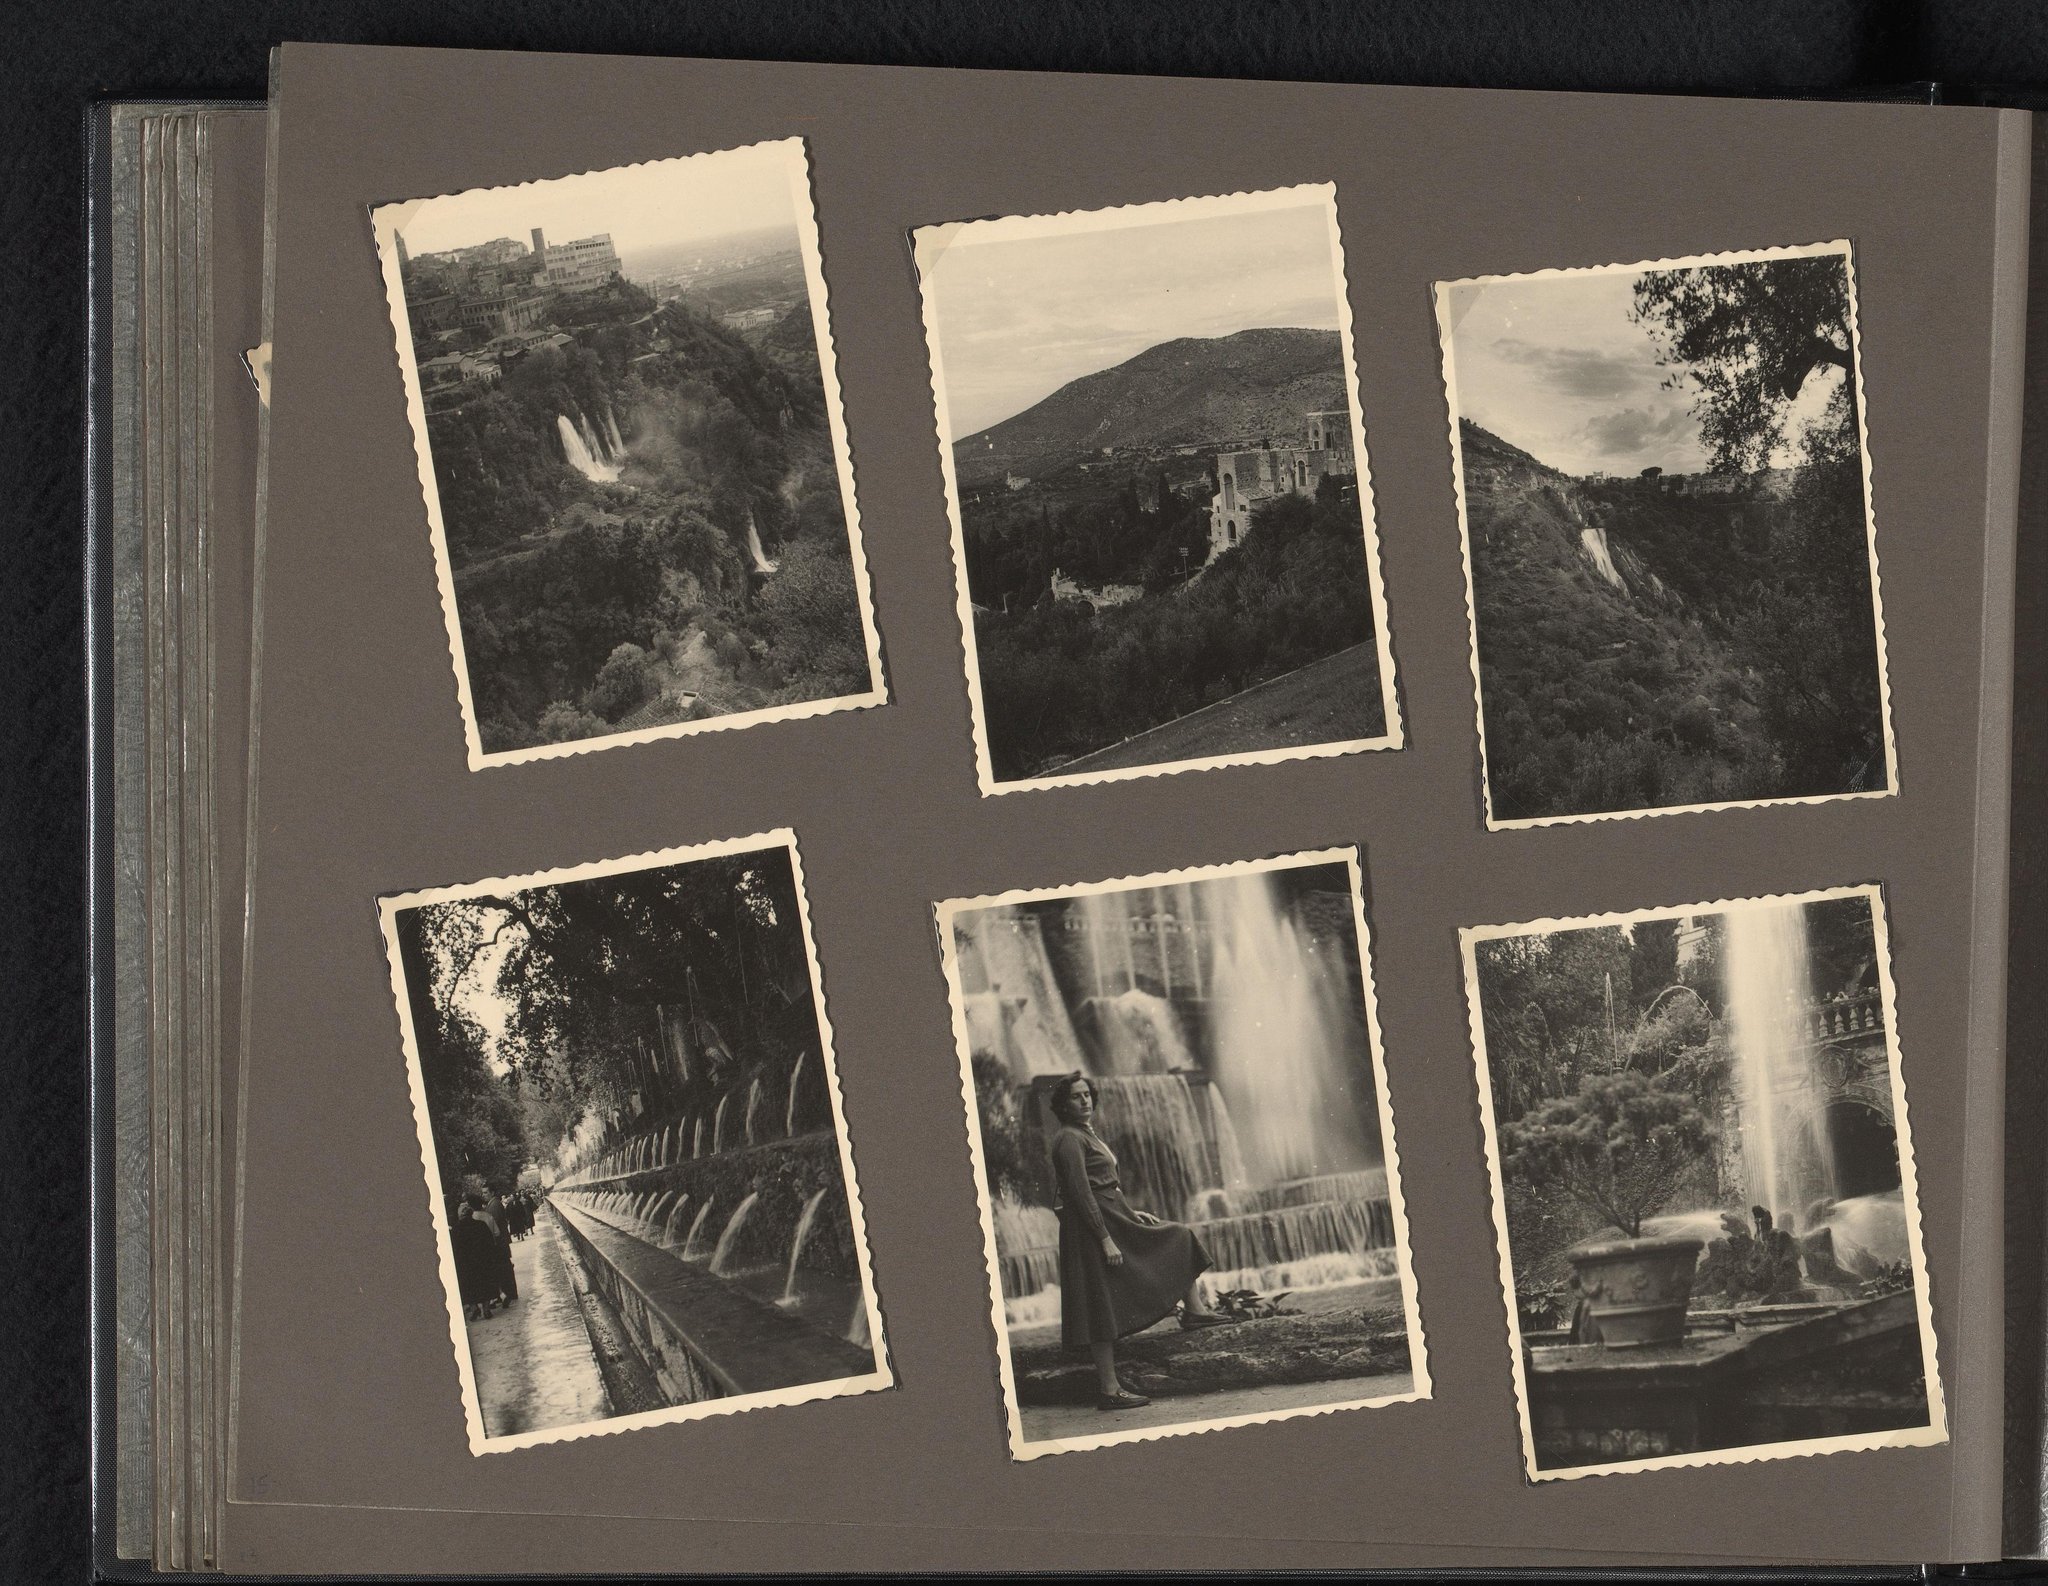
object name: album leaf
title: Isabel Wachenheimer bij de watervallen van Tivoli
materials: paper, cardboard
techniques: gelatin silver print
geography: tivoli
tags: leiden, isabel wachenheimer-elon, waterfall, historical persons, tivoli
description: Blad bevat zes foto's van Isabel Wachenheimer. Deze foto's maken deel uit van een album.